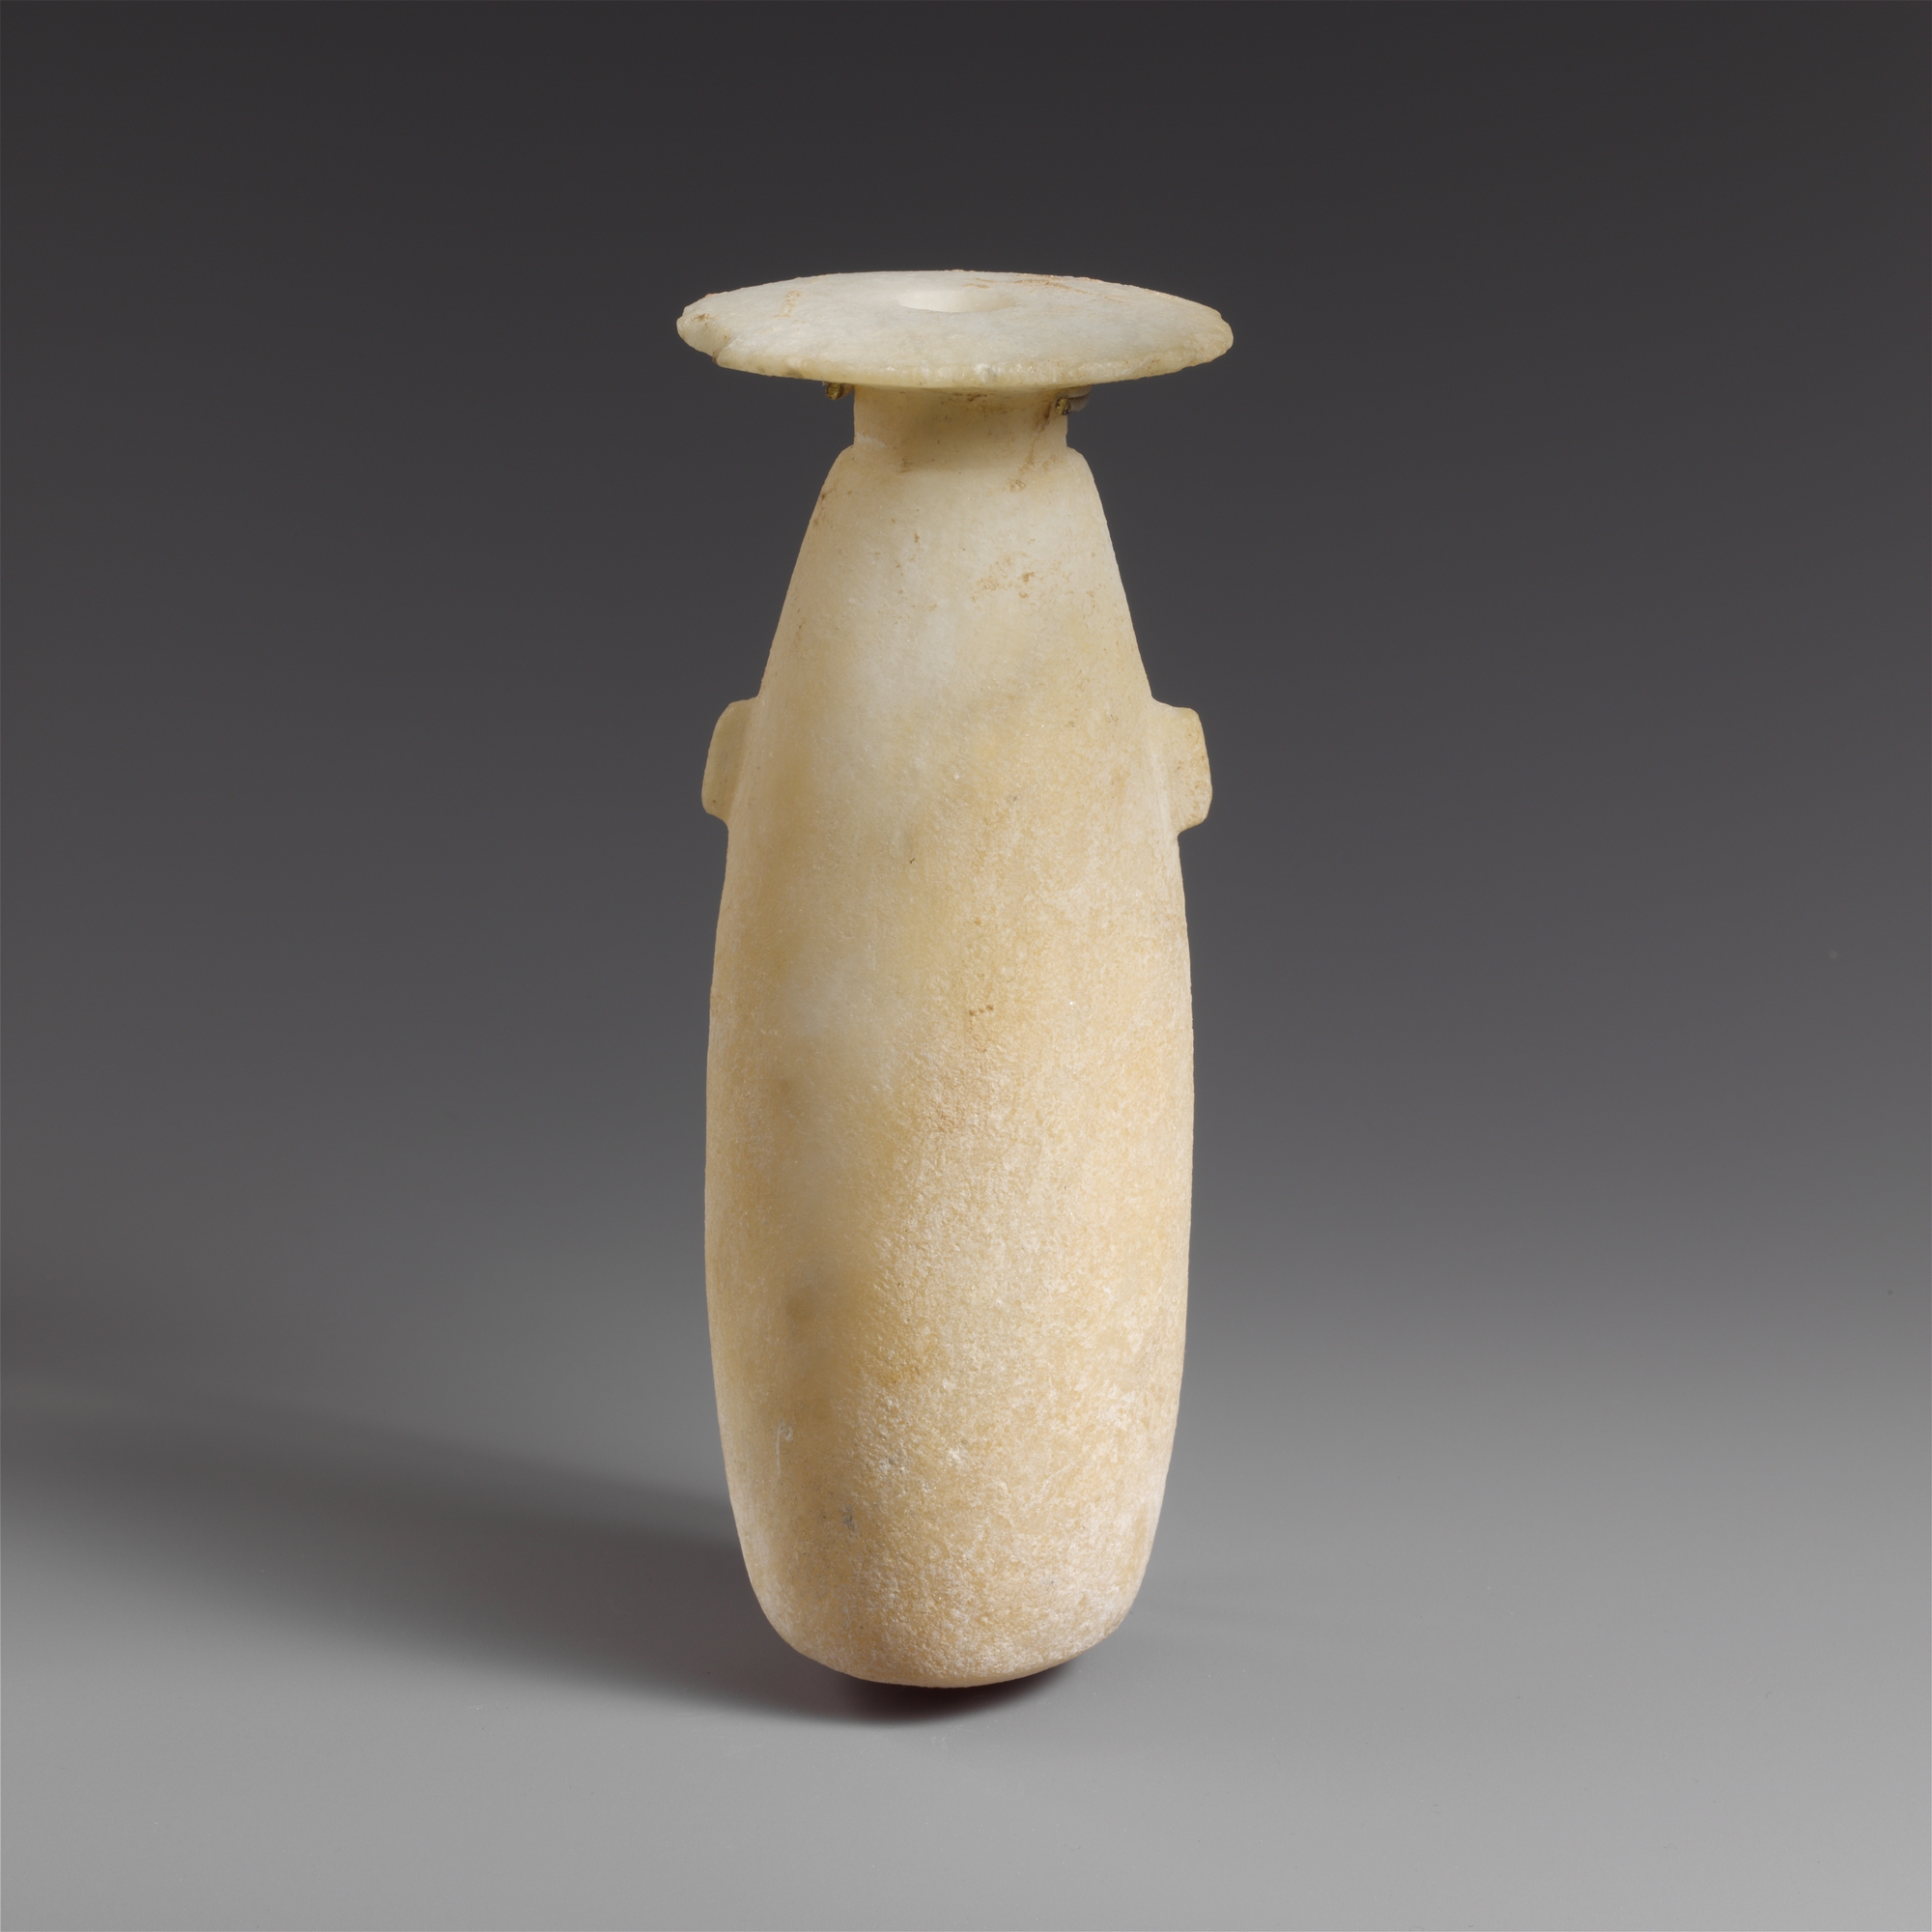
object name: alabastron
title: Alabaster alabastron (perfume vase)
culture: cypriot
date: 500-301 BCE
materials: gypsum